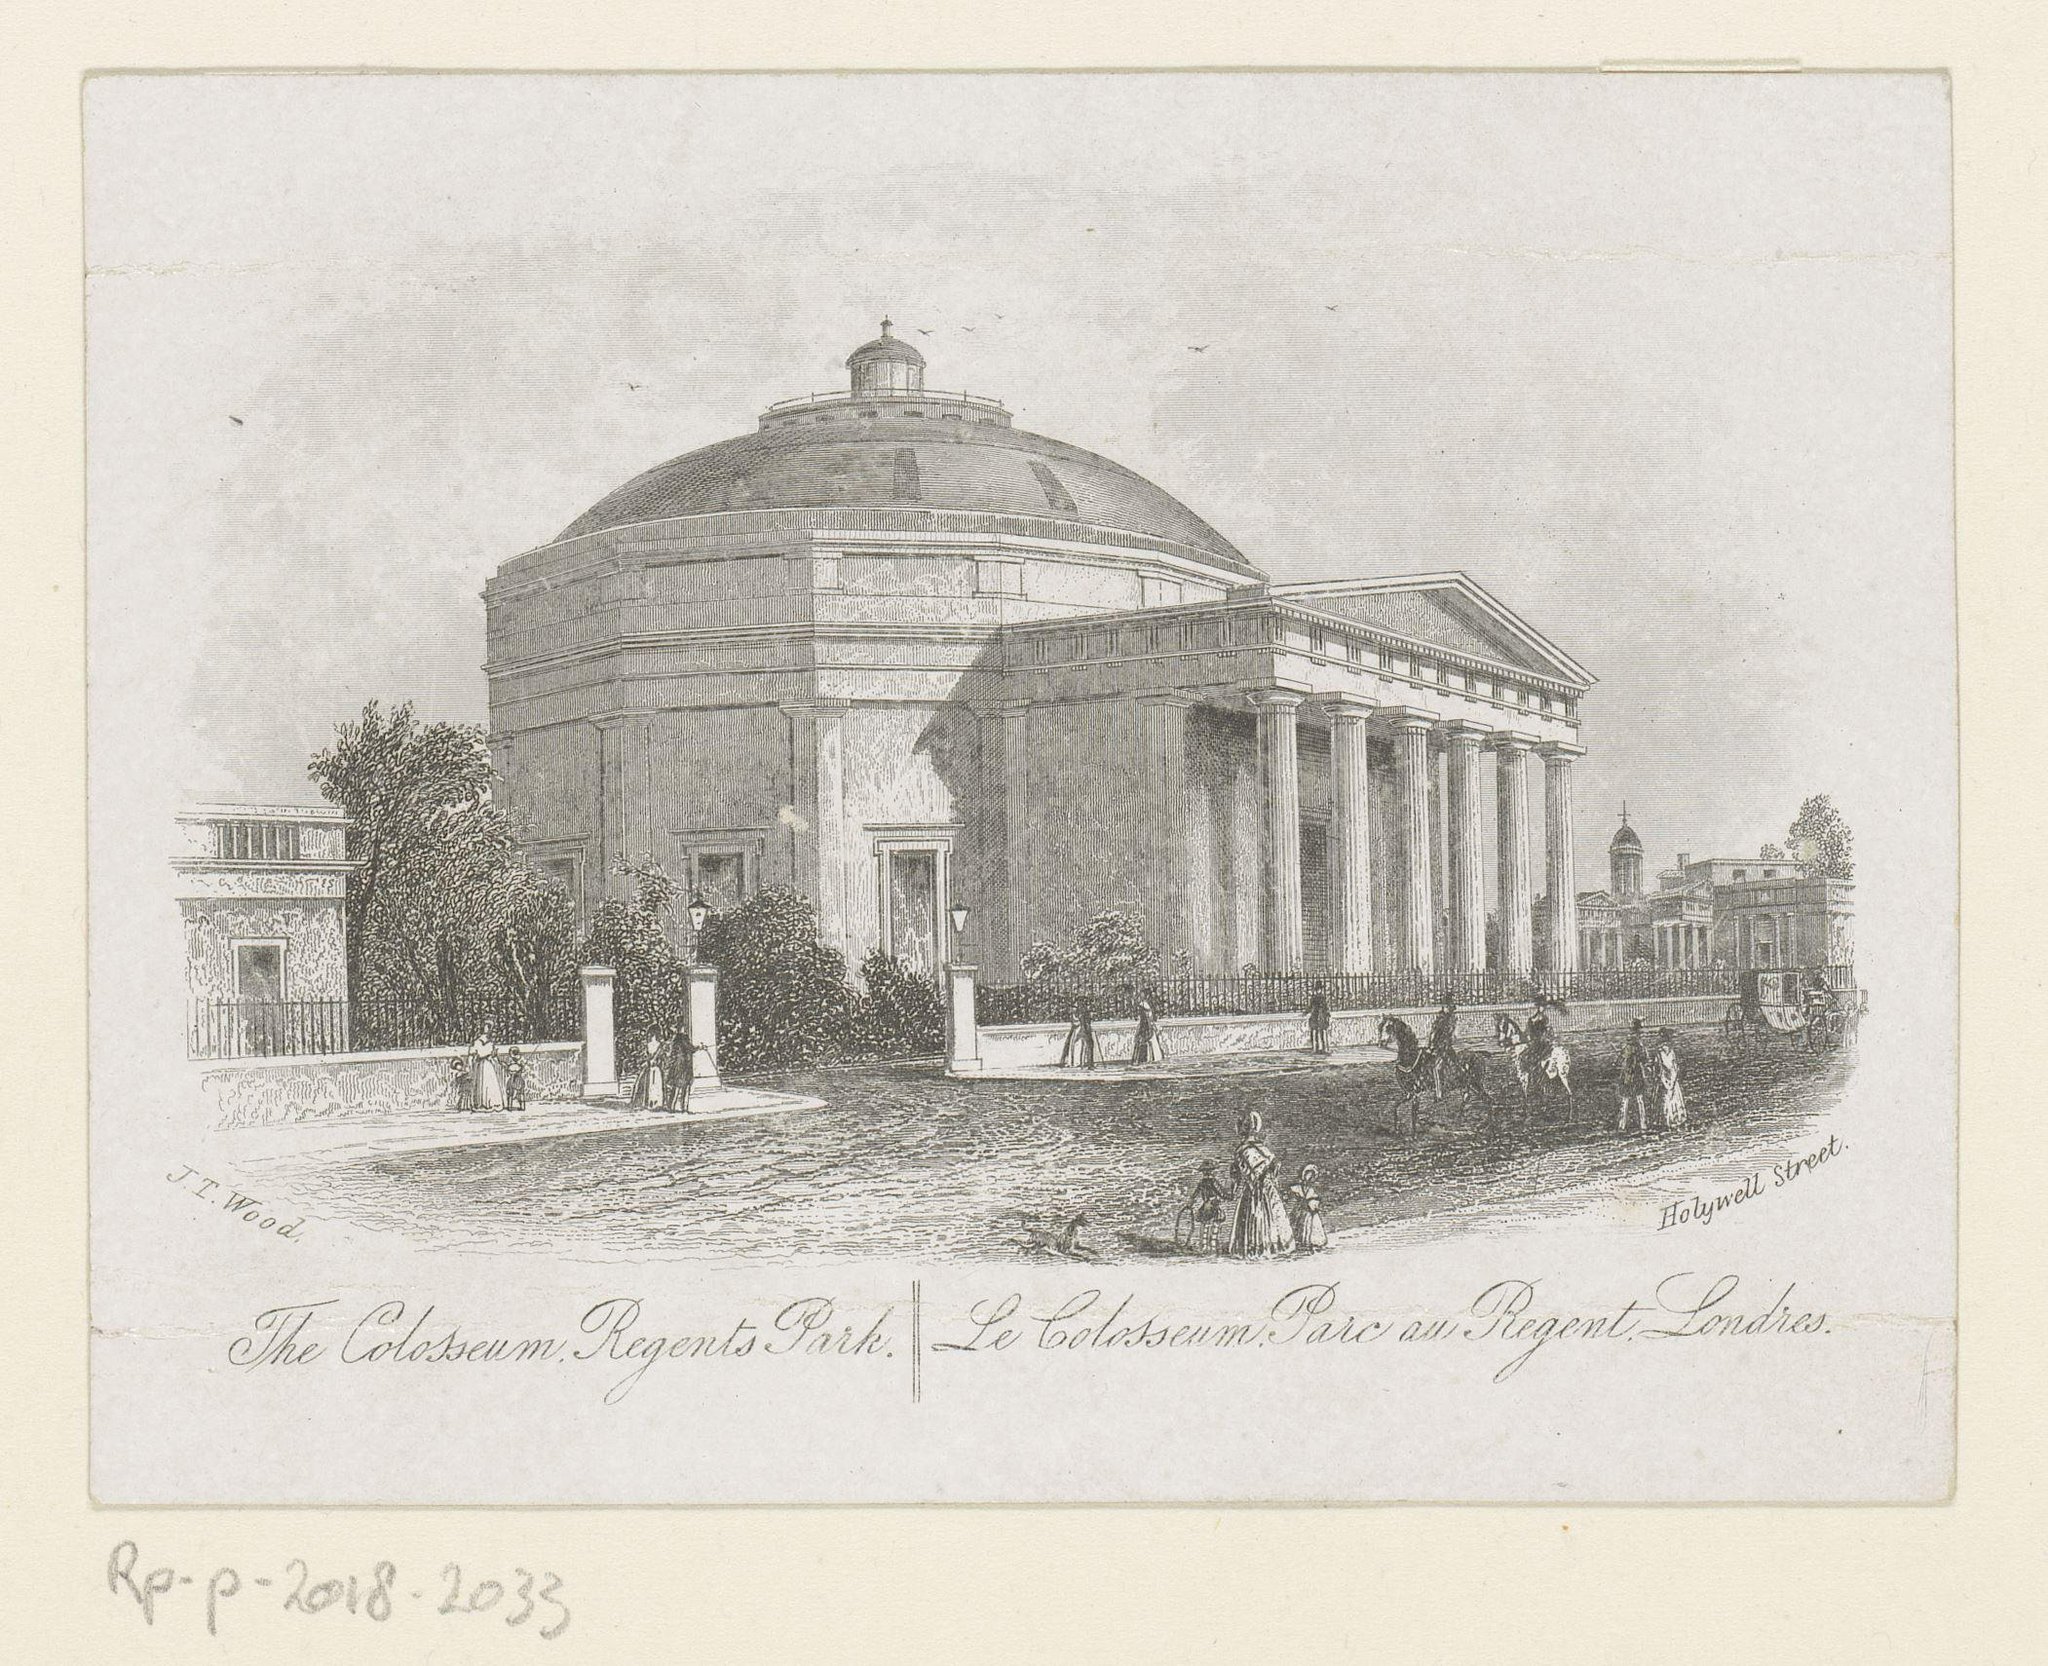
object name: print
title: Gezicht op de London Colosseum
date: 1841-1885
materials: paper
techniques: etching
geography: london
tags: permanent exhibition, museum